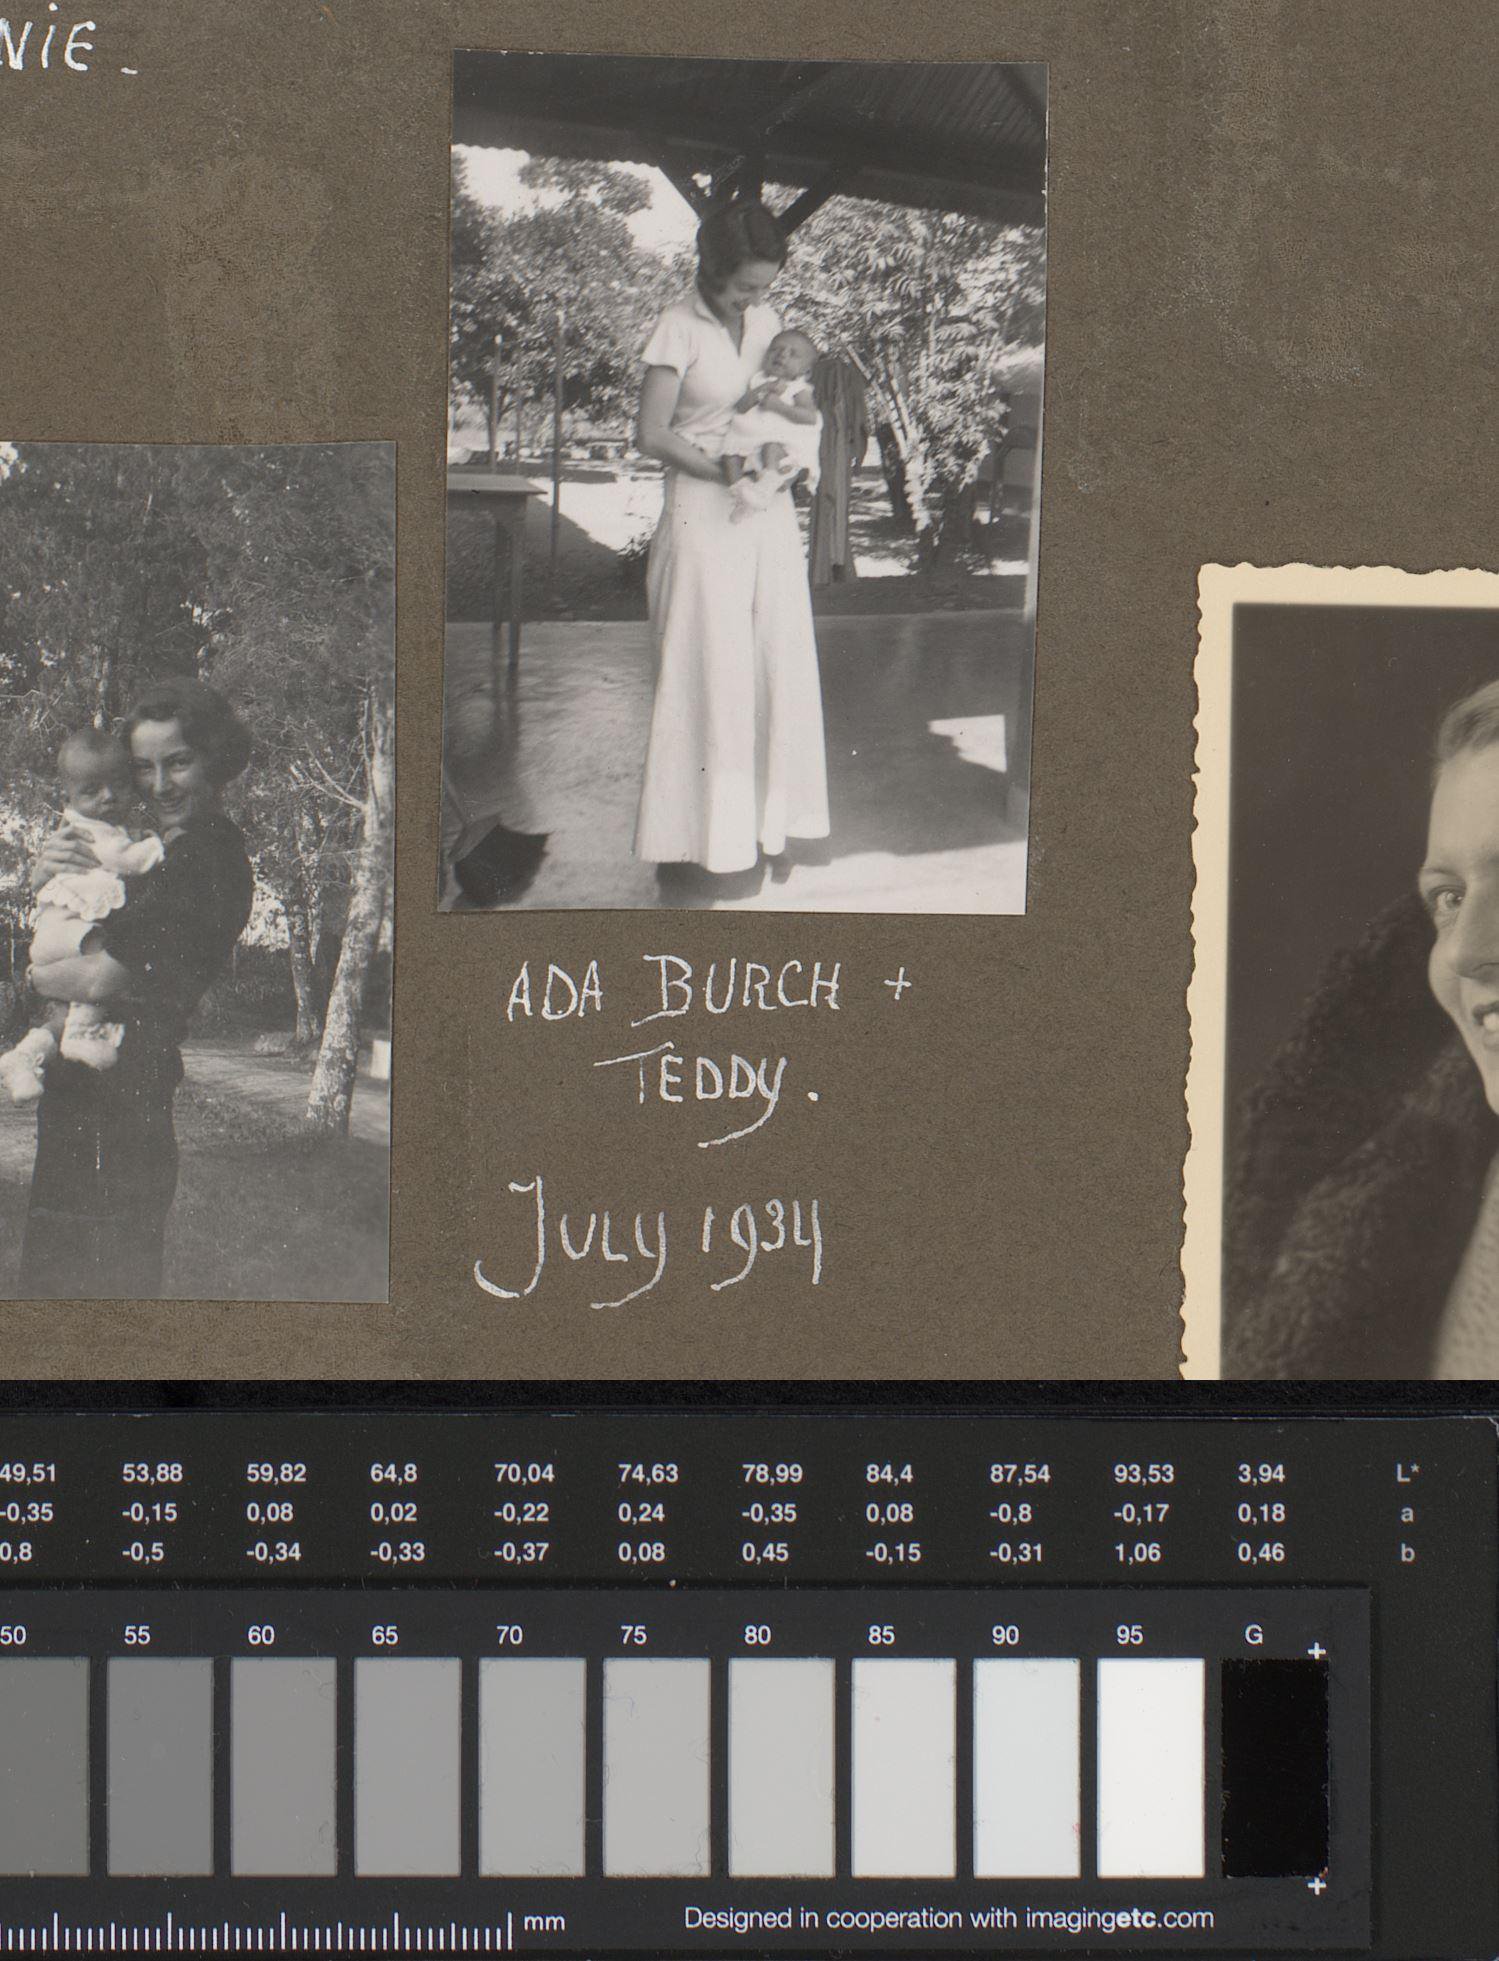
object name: photograph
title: Portret van Ada Krüseman met Teddy als baby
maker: Anonymous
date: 1907-1934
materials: paper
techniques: gelatin silver print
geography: dutch east indies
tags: historical persons - bb - woman, mother and baby or young child, dutch east indies, the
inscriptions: inscription: ‘Ada Burch +/ Teddy./ July 1934’